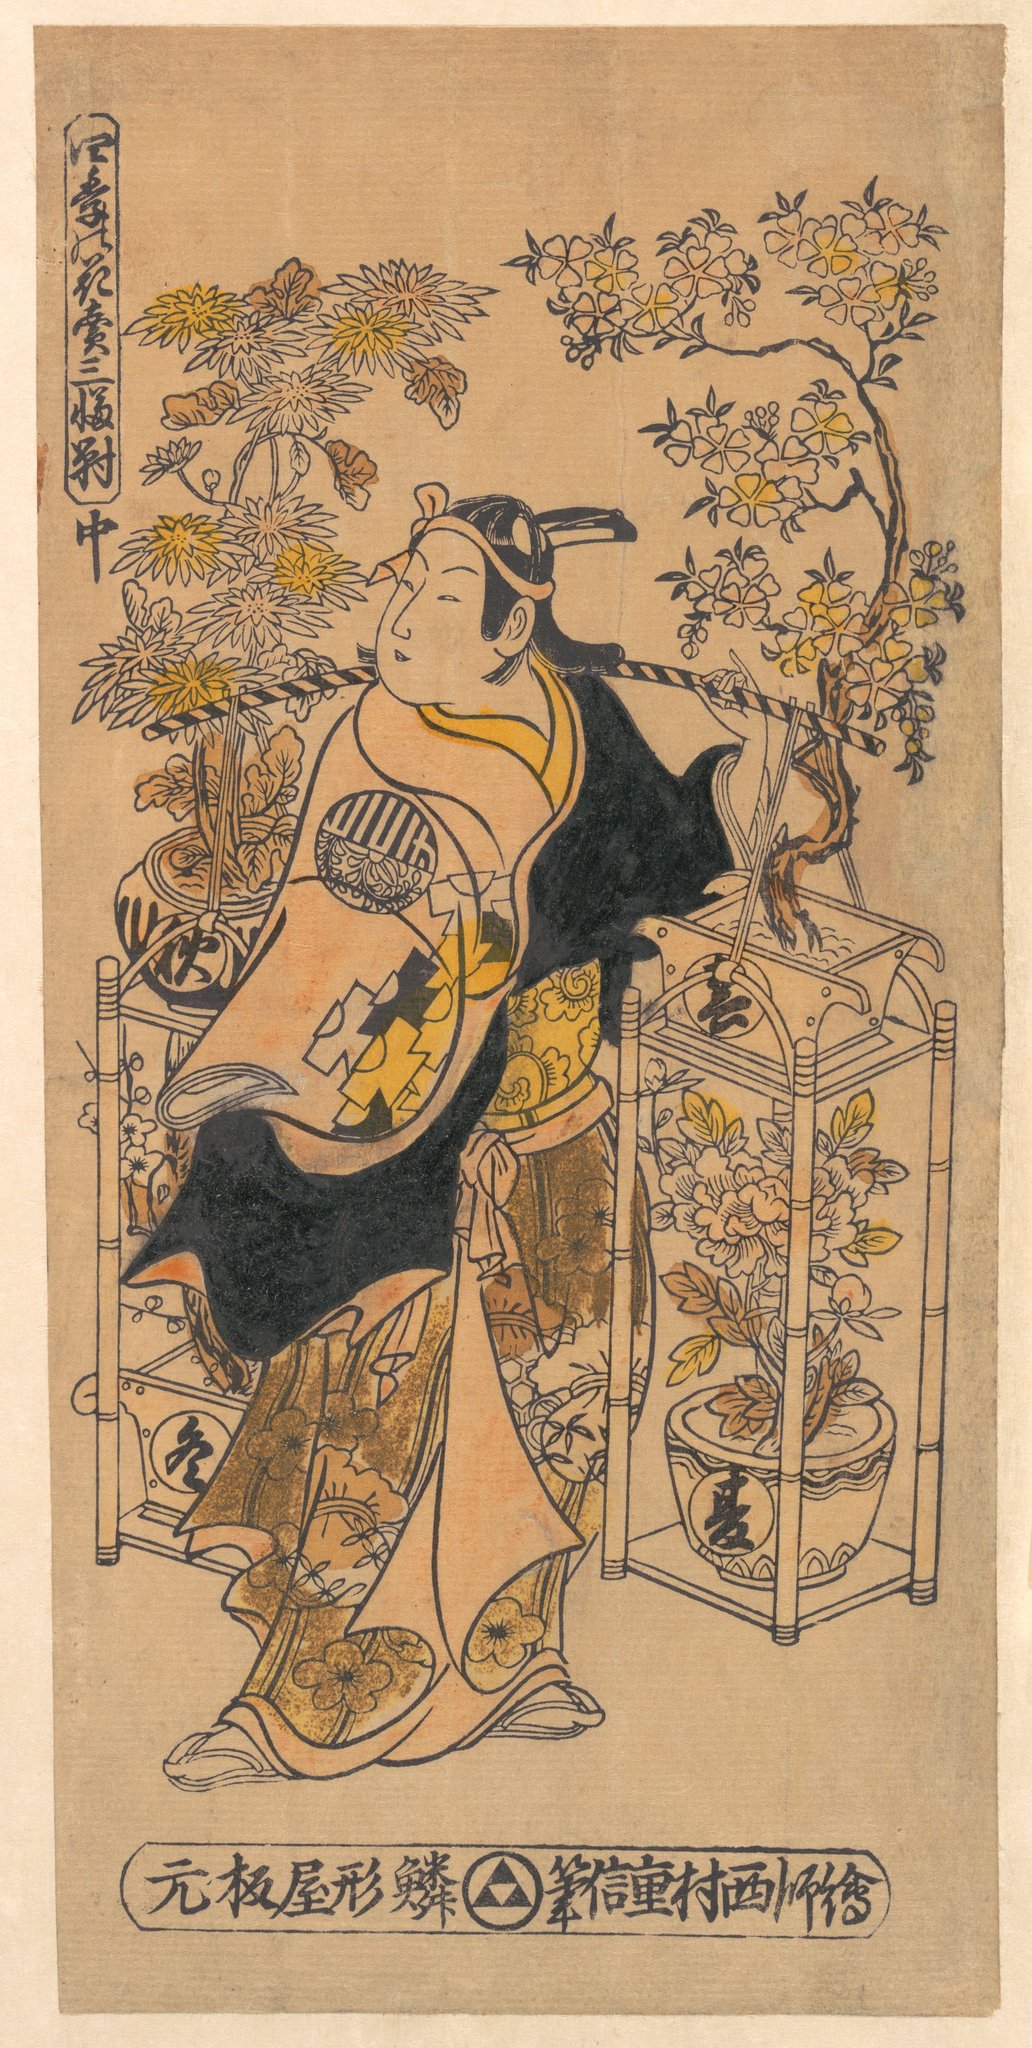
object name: print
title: The Actor Ogino Isaburō as an Itinerant Flower Vendor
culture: japanese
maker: nishimura shigenobu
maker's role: artist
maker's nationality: japanese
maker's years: 1729-1739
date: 1738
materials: ink, paper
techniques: woodblock print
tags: men,flowers,actors